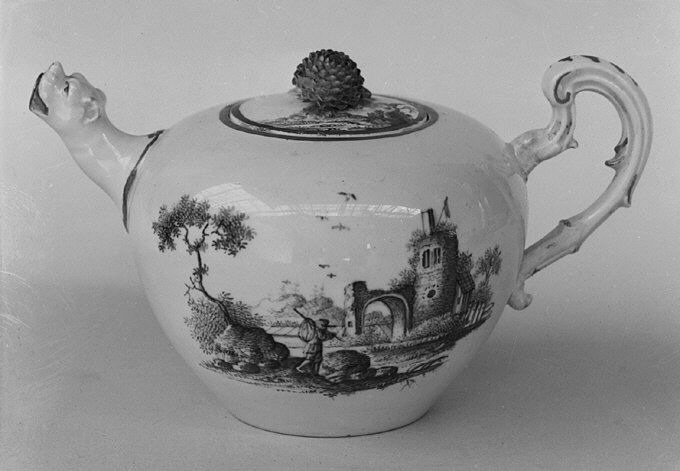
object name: teapot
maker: ansbach pottery and porcelain manufactory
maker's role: manufactory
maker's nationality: german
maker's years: 1758-1860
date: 1770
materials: hard paste porcelain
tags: ruins,men,trees